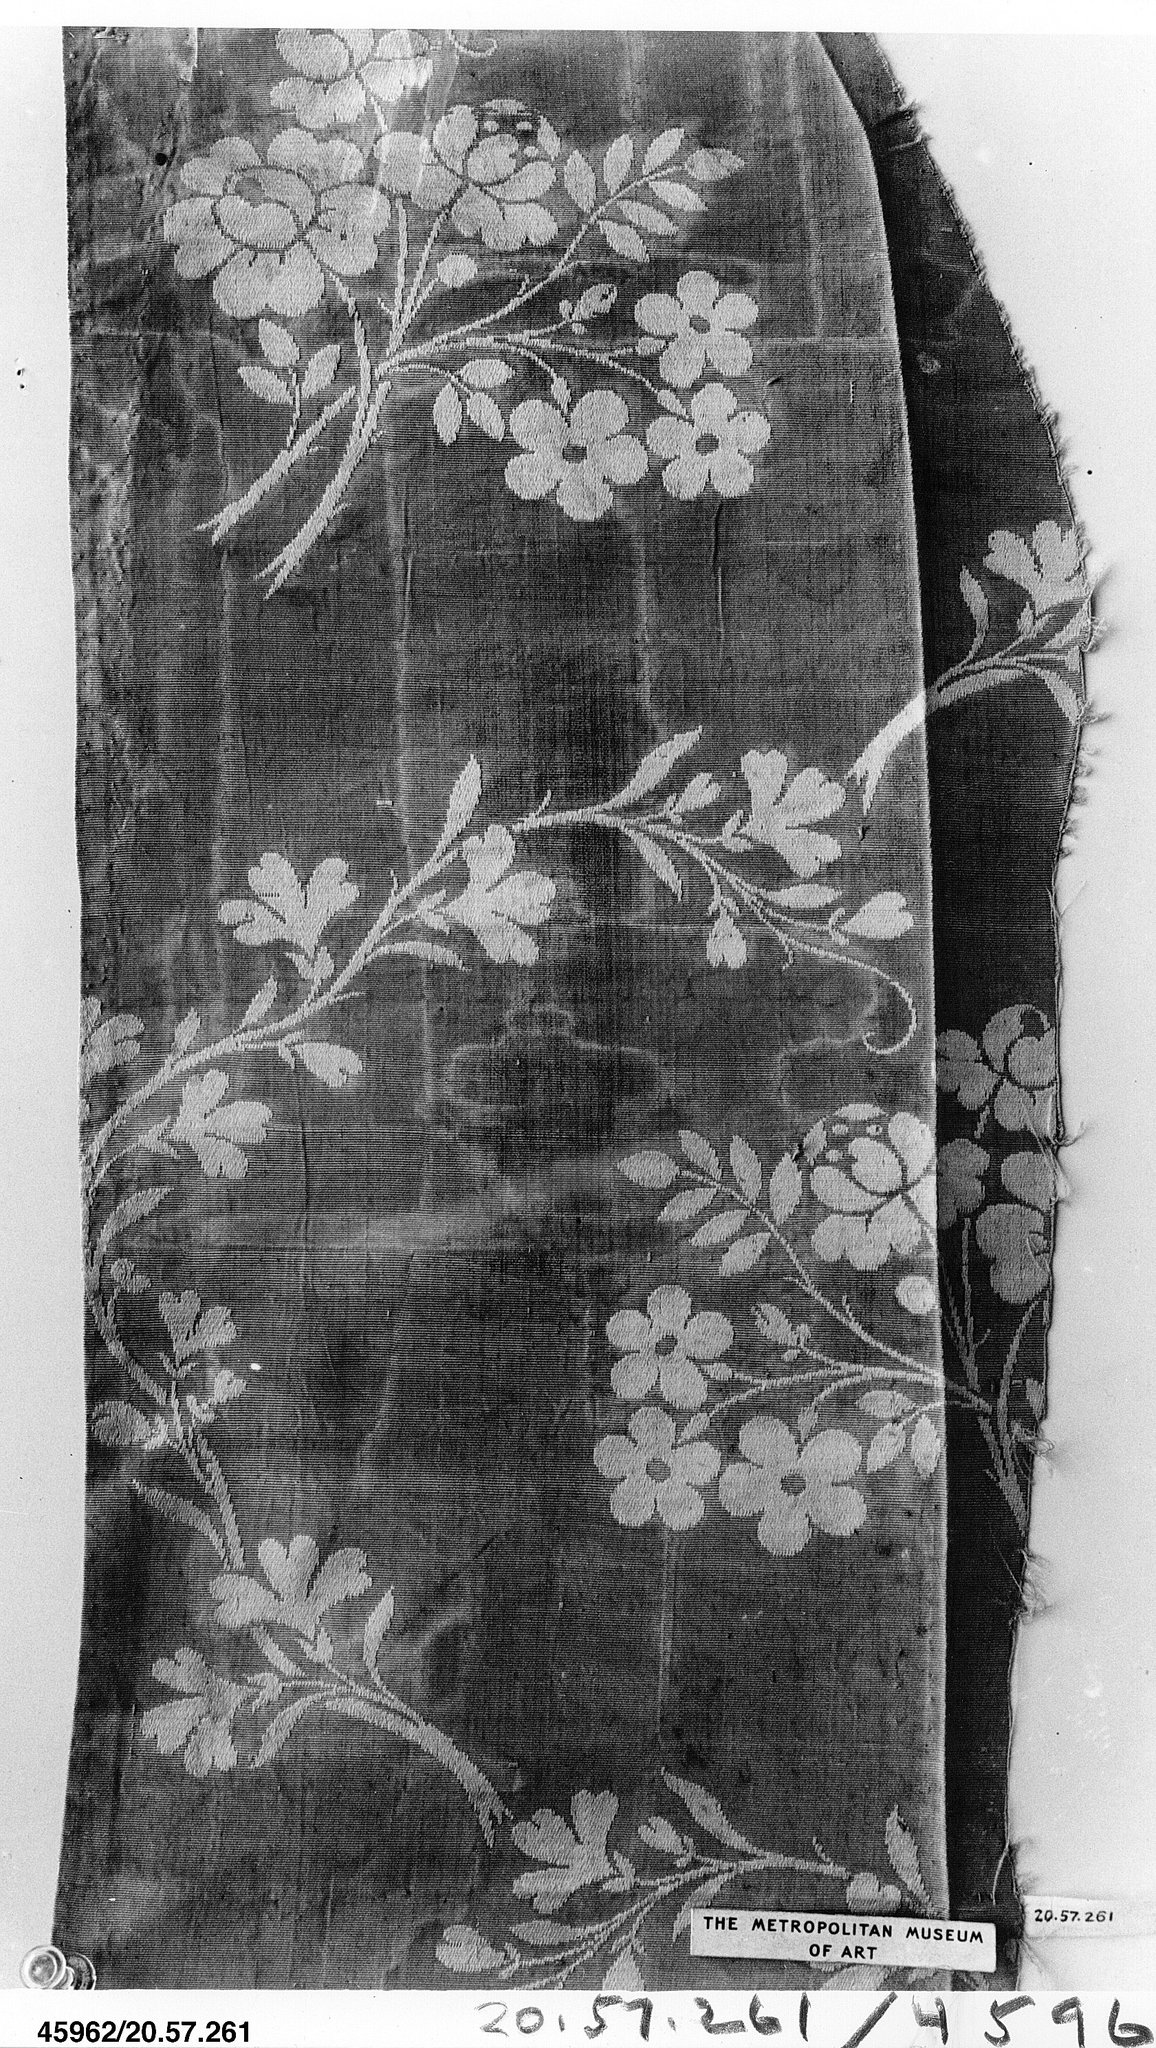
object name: piece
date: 1750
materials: silk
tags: flowers,leaves